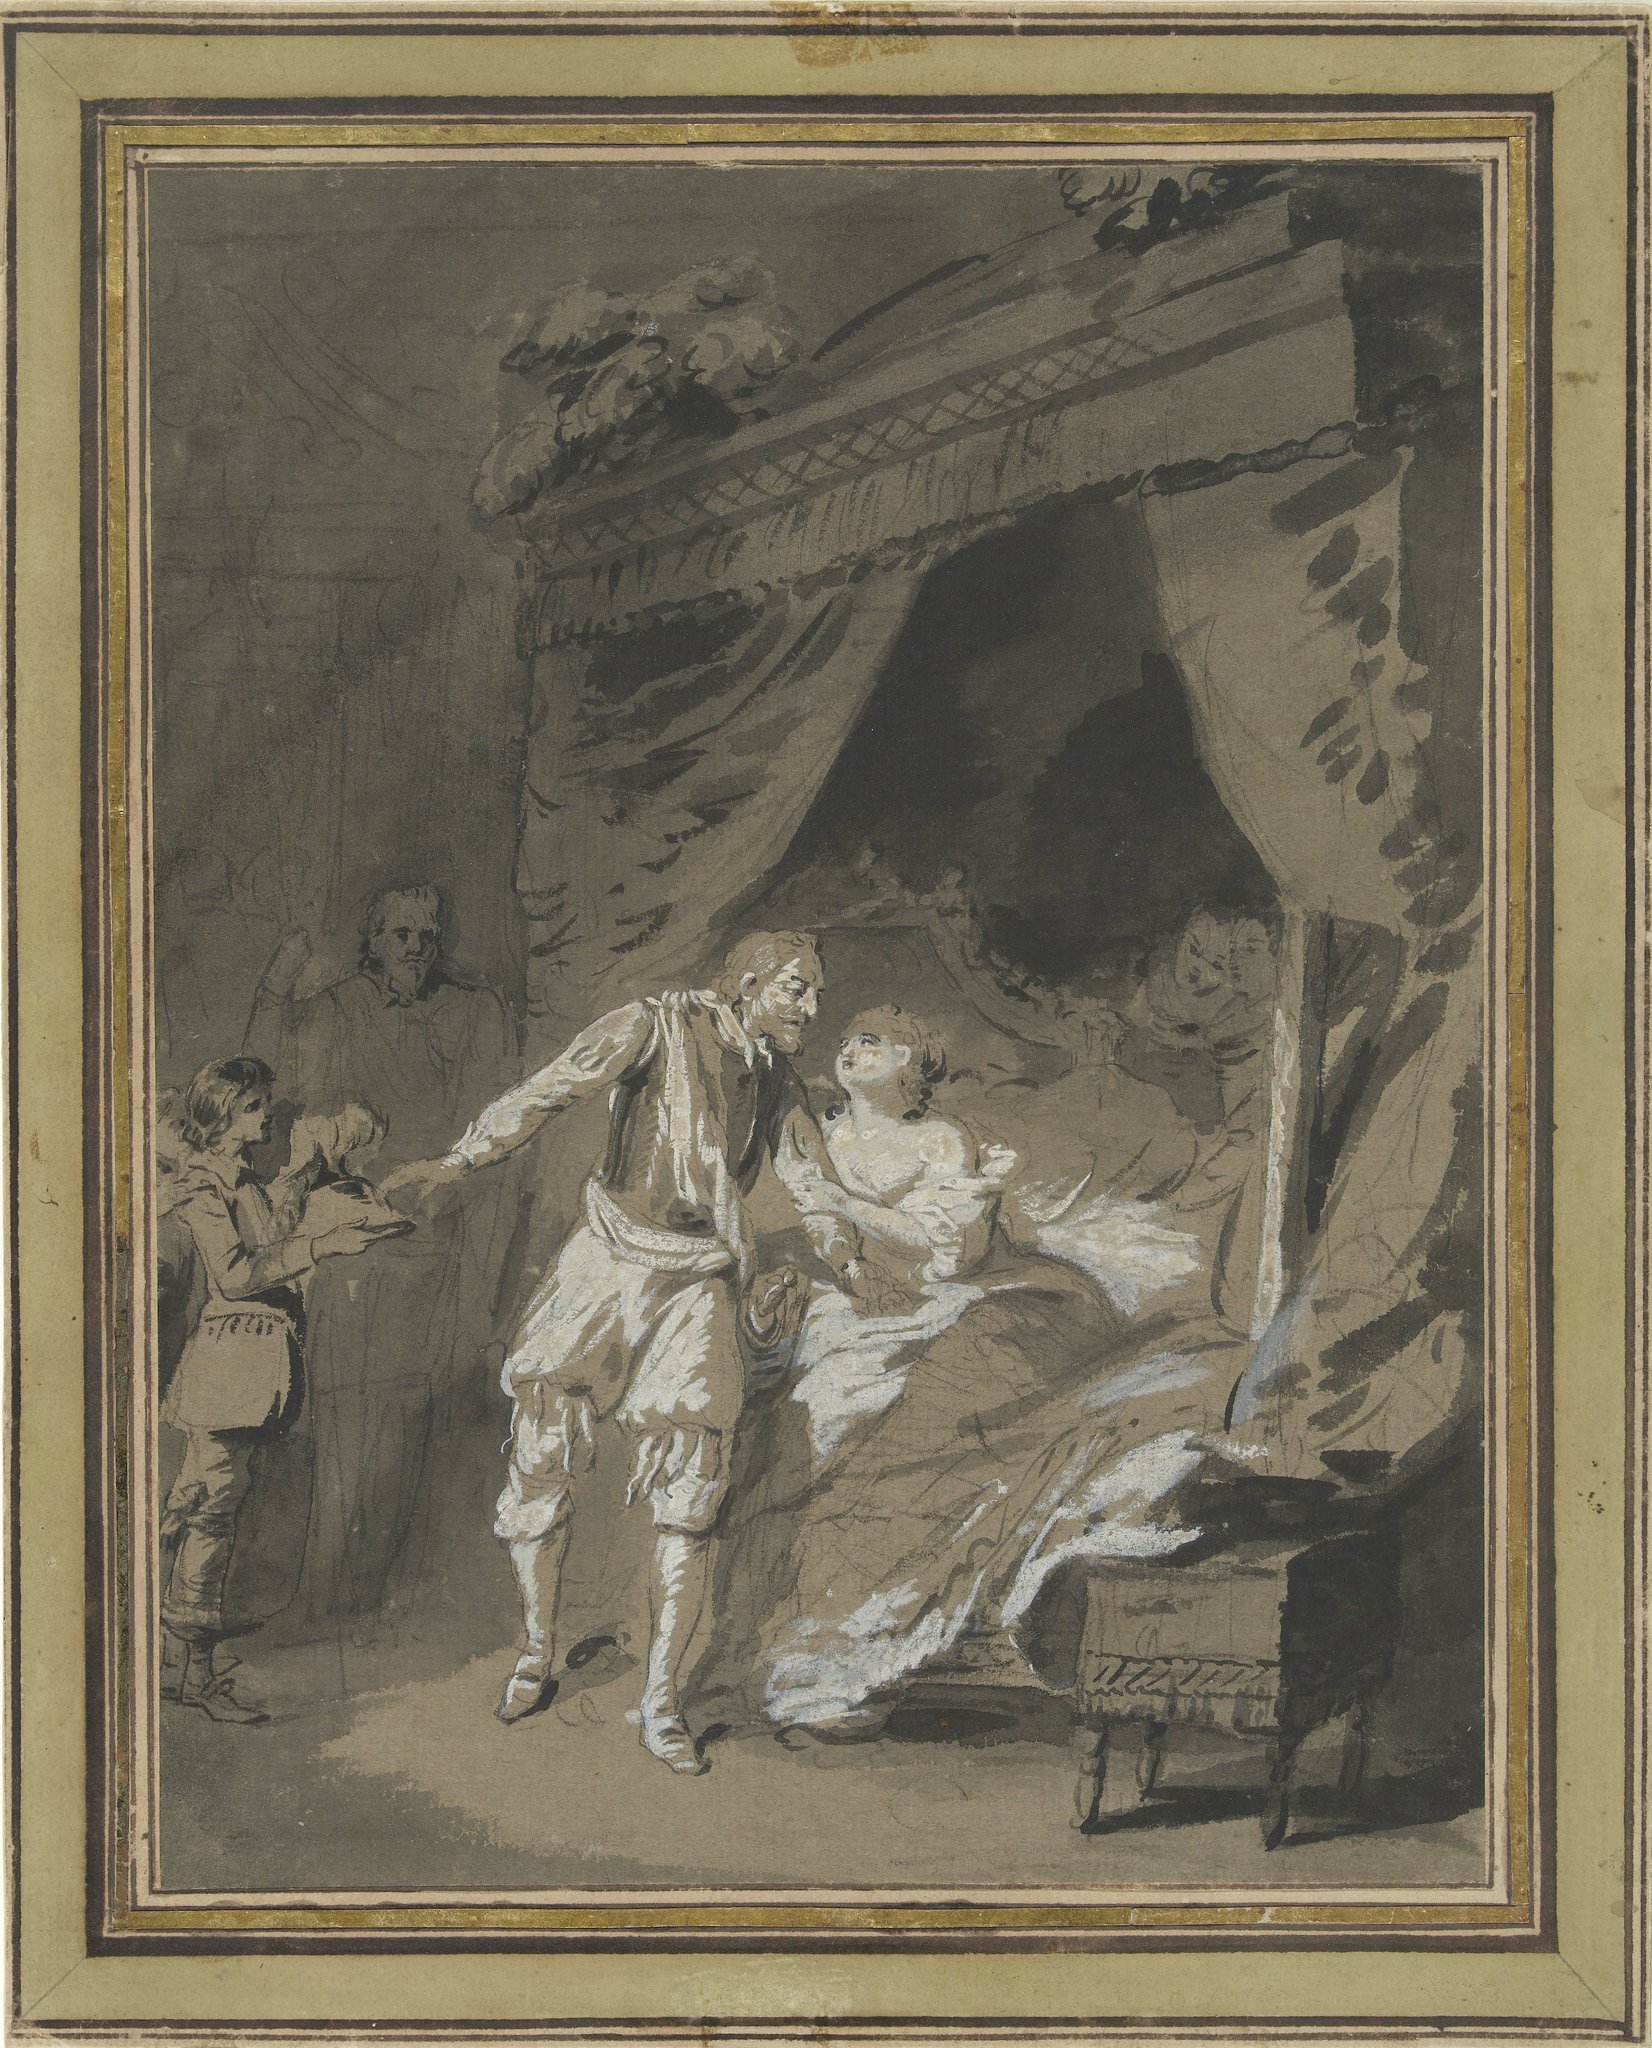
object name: drawing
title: Afscheidsscène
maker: Anonymous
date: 1700-1800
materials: ink, paper, pencil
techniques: brush, pen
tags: taking leave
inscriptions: collector's mark, verso, lower centre: Lugt 2228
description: Historische voorstelling: afscheidsscène.